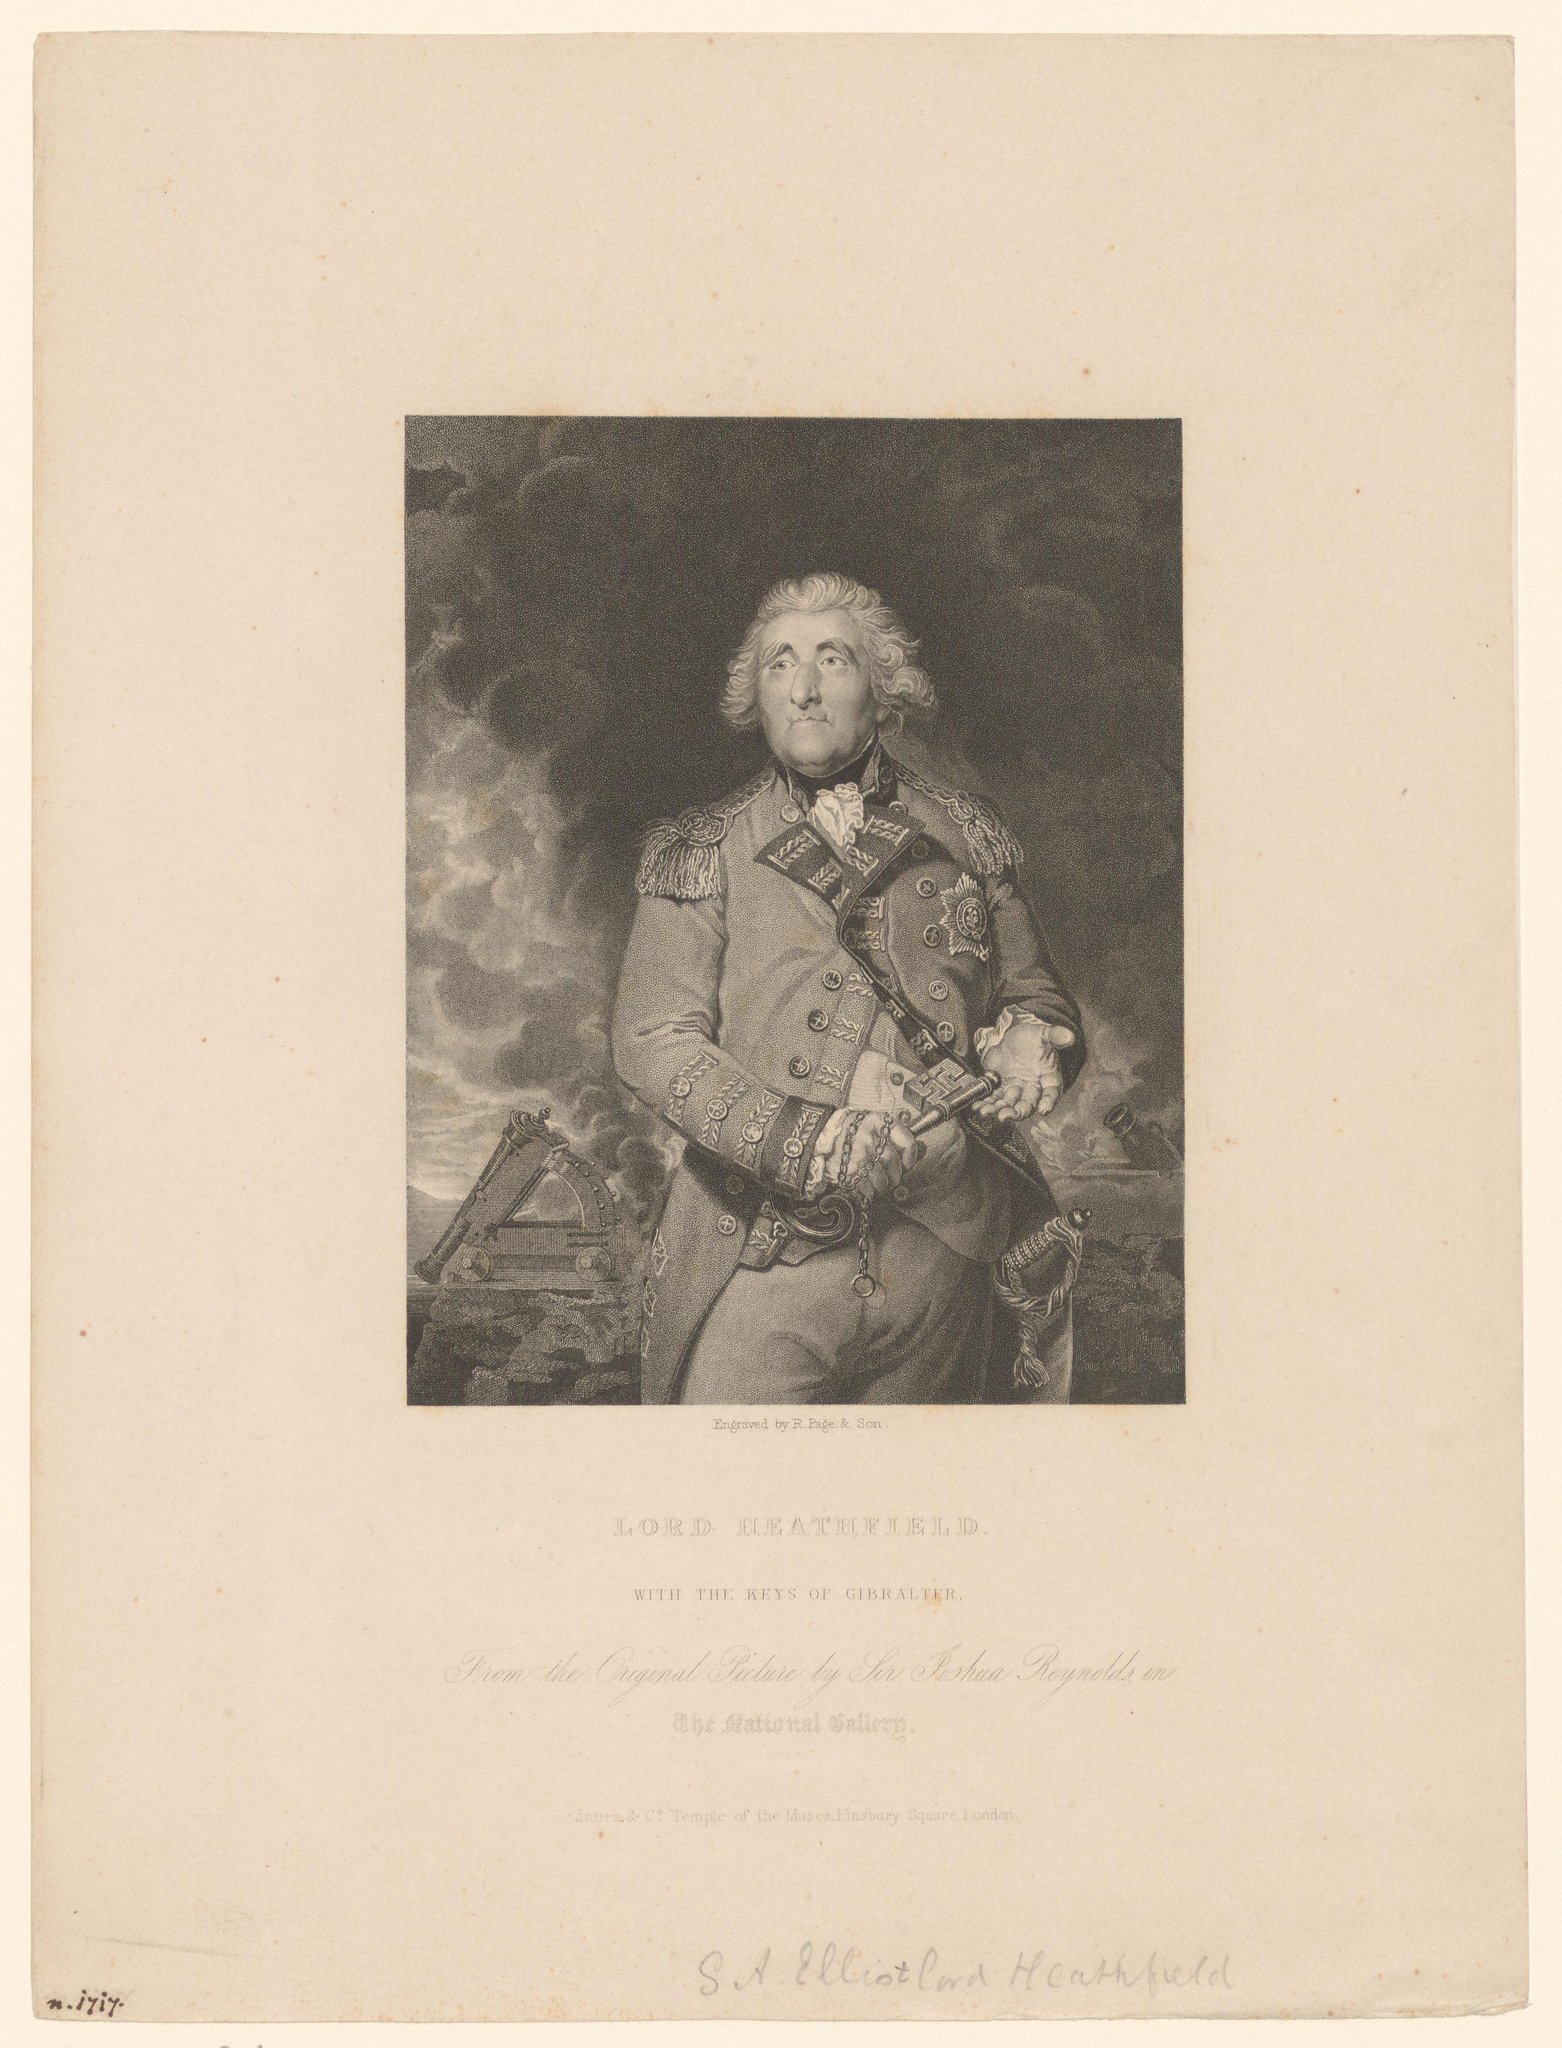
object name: print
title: Portret van George Augustus Eliott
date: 1836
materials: paper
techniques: etching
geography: london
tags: historical persons, officer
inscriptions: collector's mark: Lugt 2228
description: Prent uit: The National Gallery of Pictures by the Great Masters (...). Londen: Jones & Co, 1836.